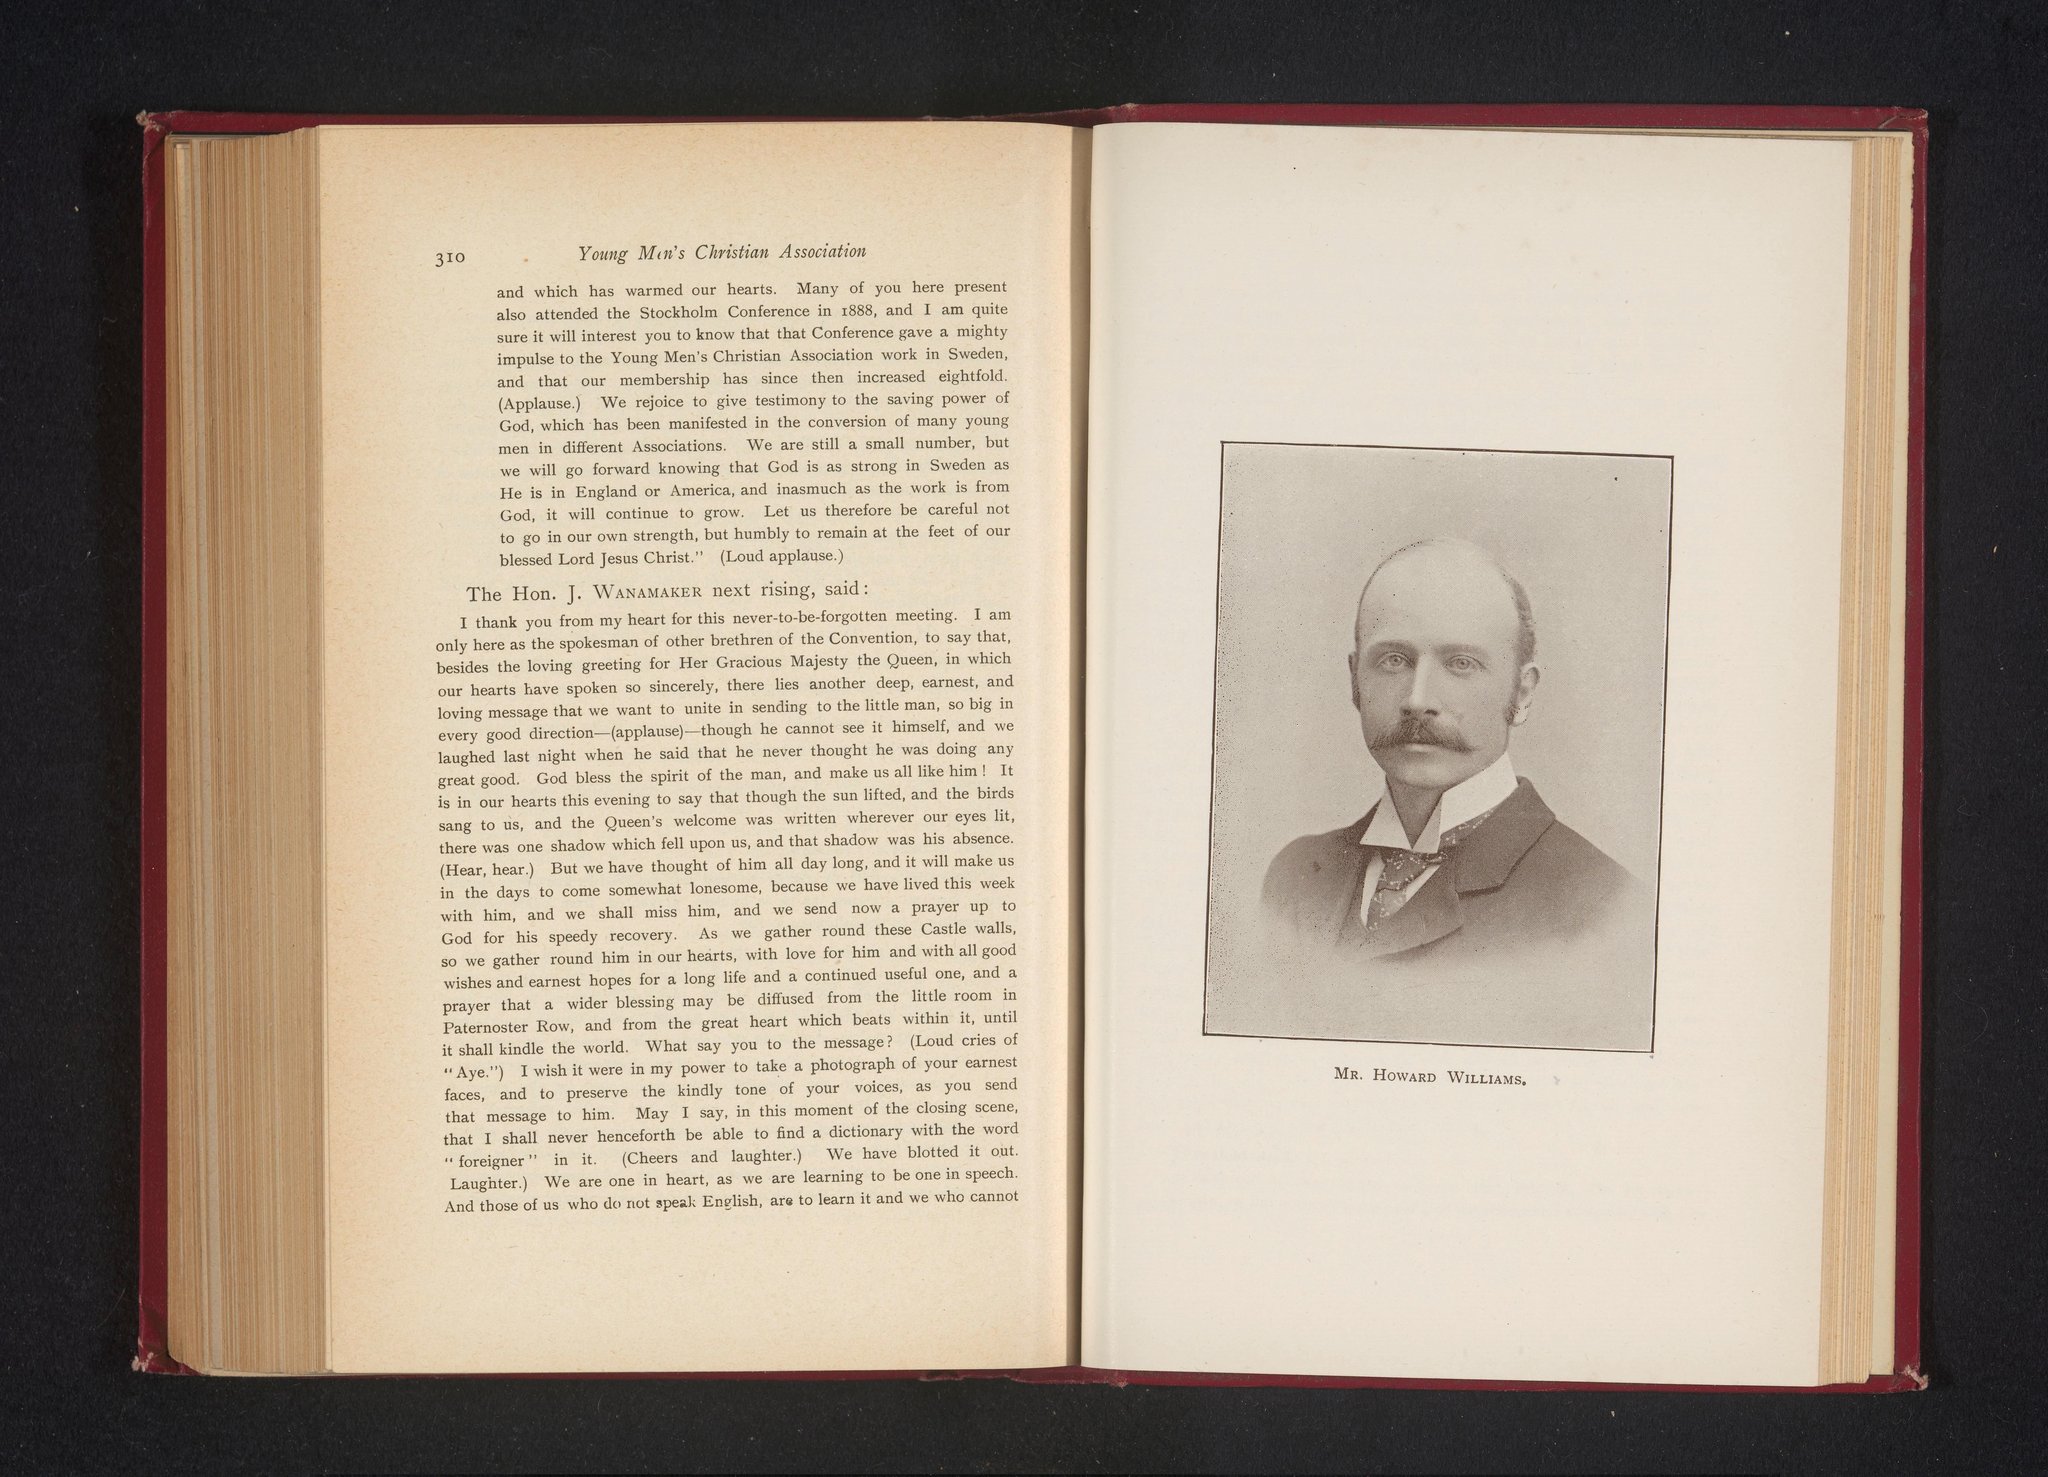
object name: photomechanical print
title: Portret van Howard Williams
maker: Anonymous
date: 1890-1895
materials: paper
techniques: autotype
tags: historical persons